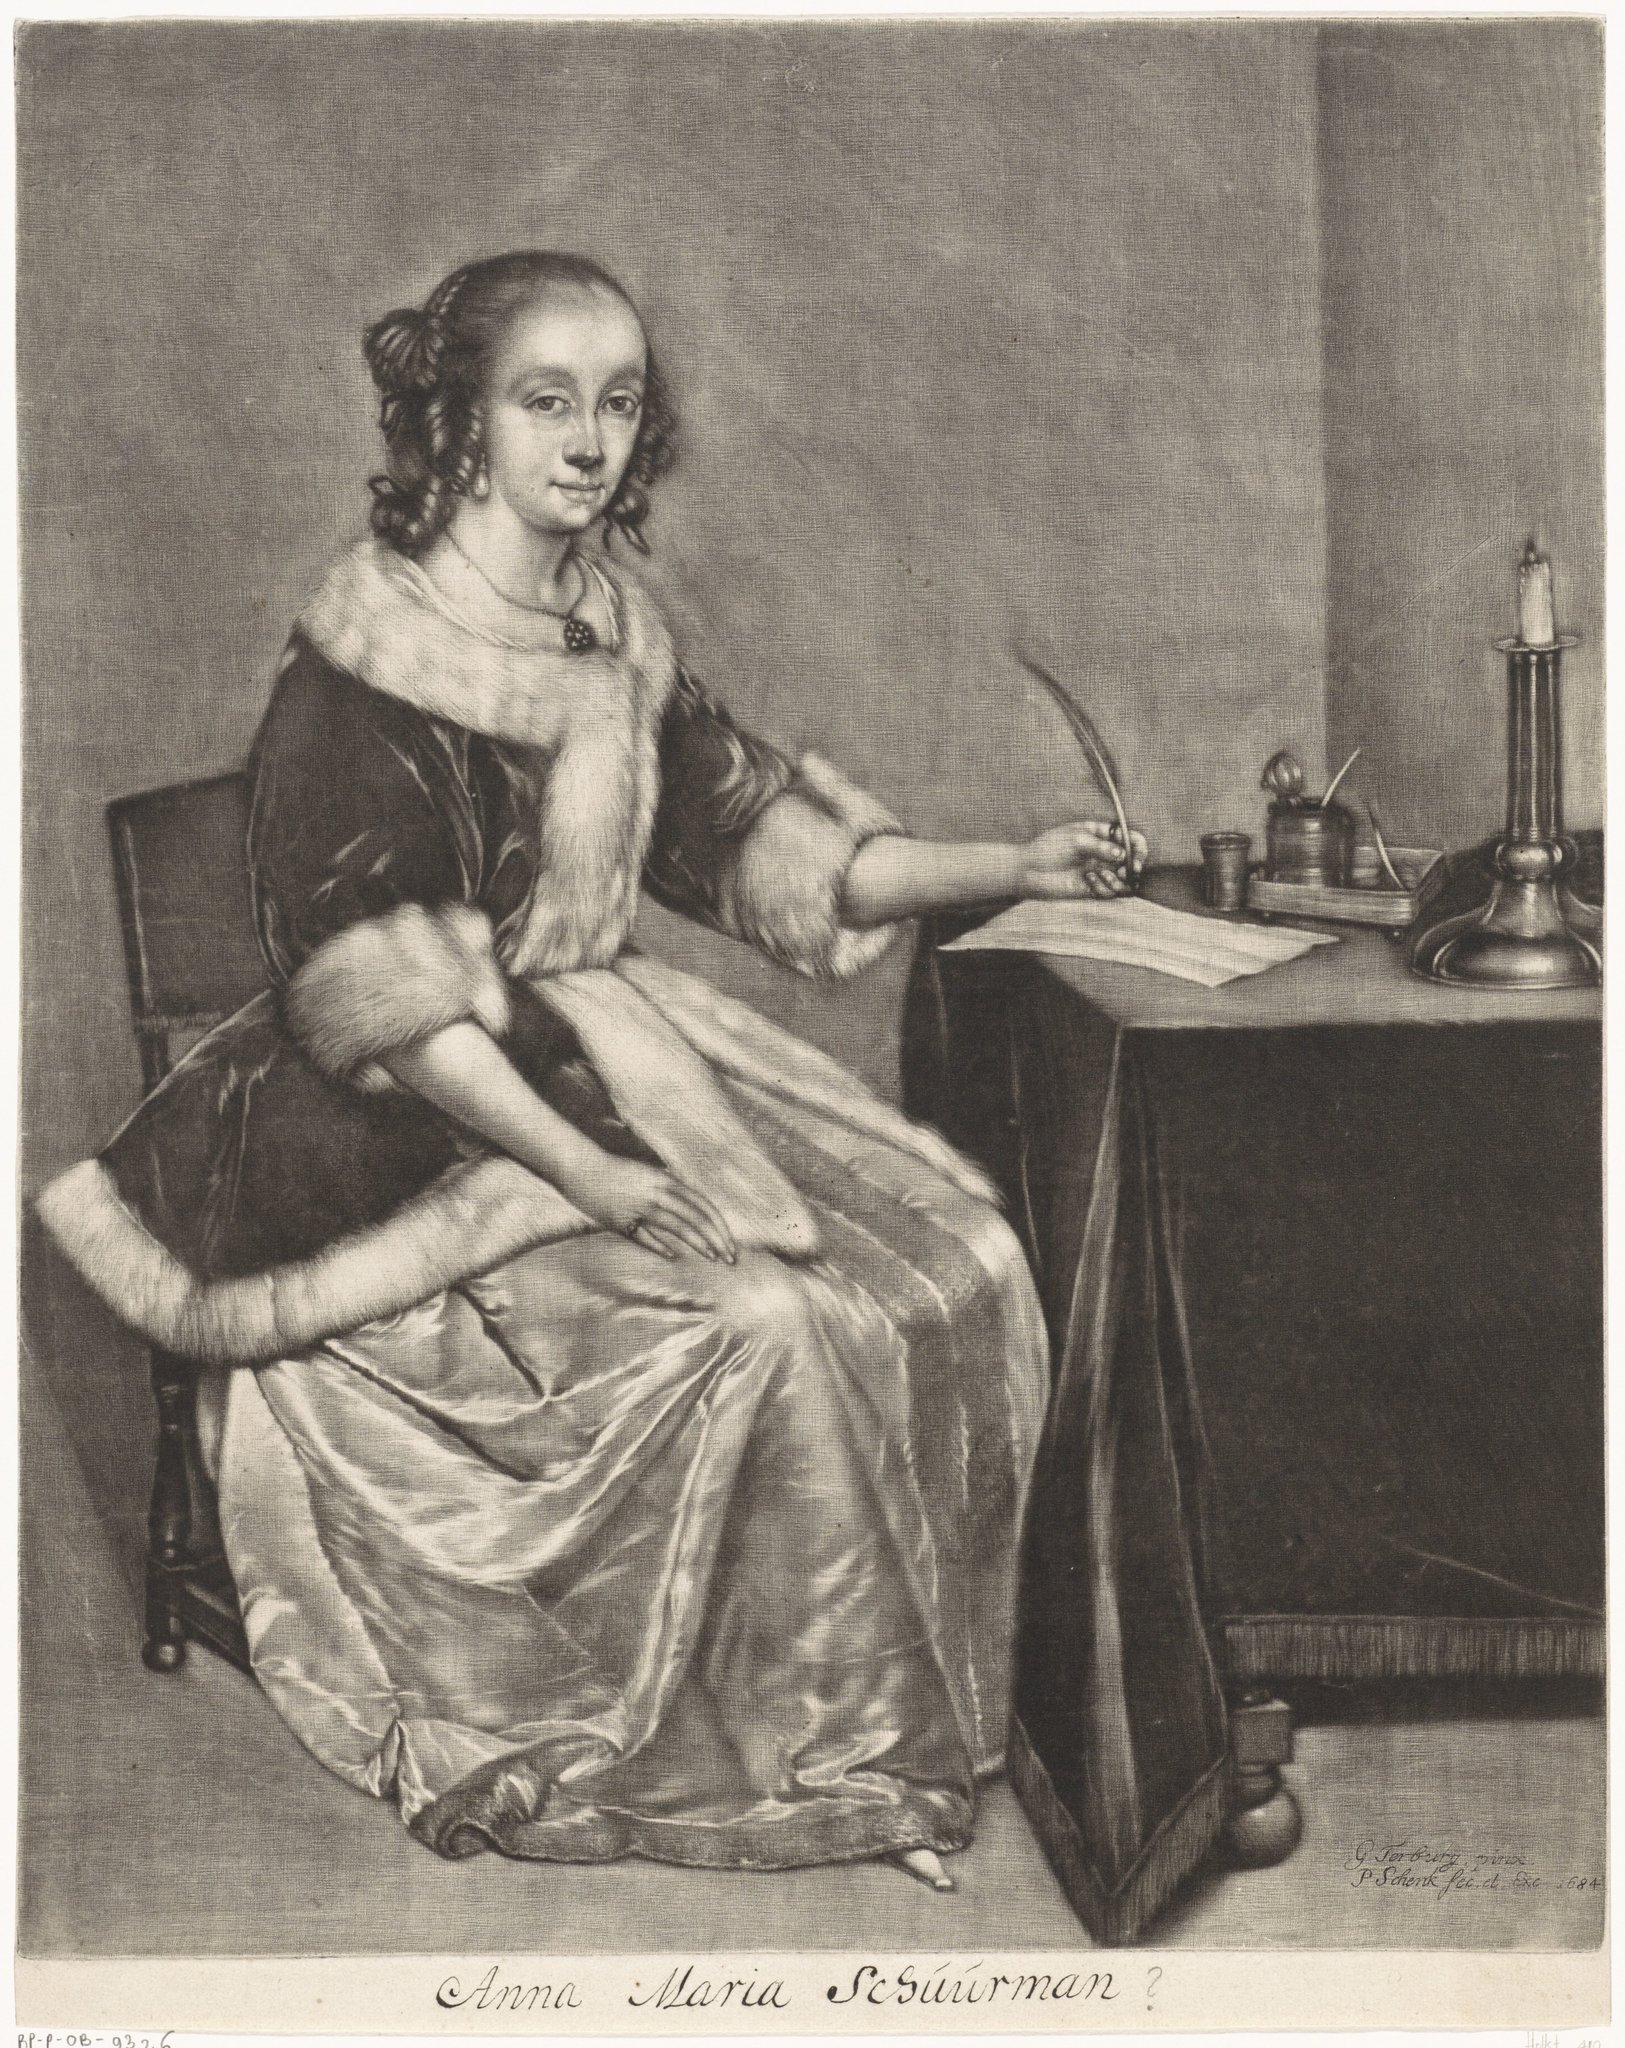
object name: print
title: Briefschrijvende vrouw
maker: pieter schenk (i)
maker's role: print maker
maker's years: 1660-1711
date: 1684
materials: paper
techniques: engraving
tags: handwriting, writing as activity, writing tools, letter, envelope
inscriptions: inscription: ‘Anna Maria Schuurman’, collector's mark: Lugt 240